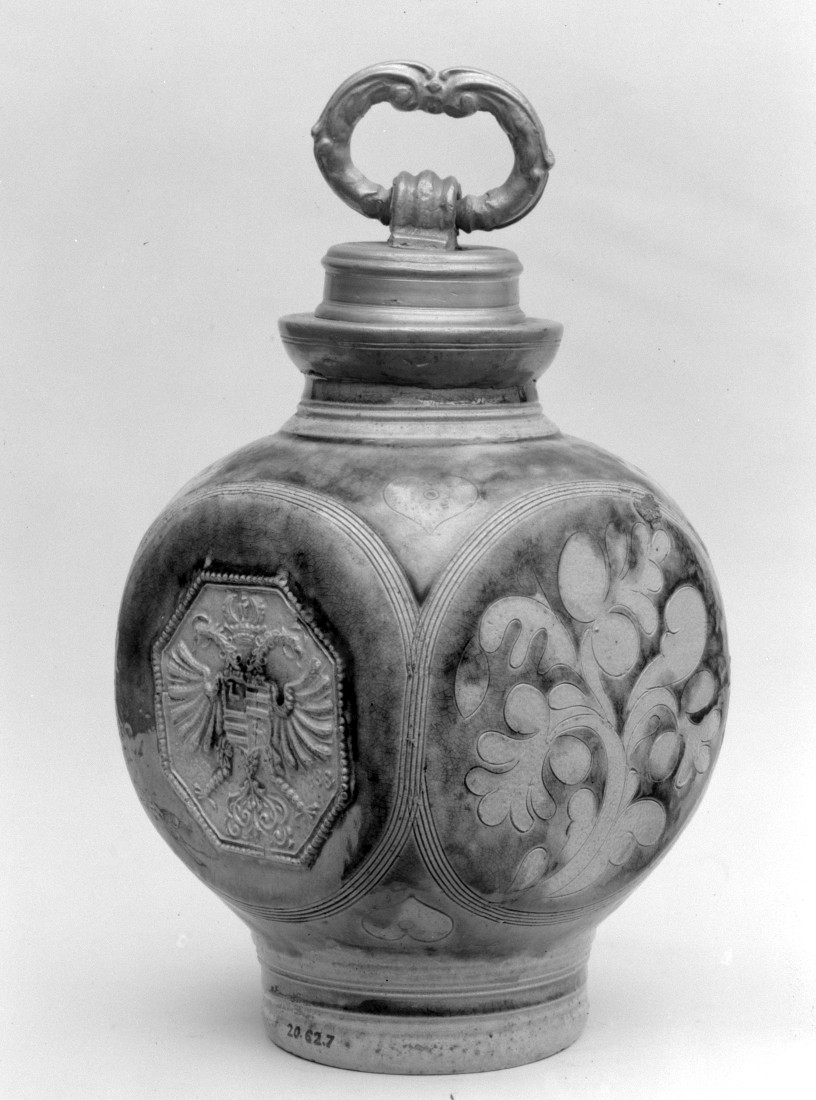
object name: bottle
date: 1667-1700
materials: pewter, stoneware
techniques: salt glaze